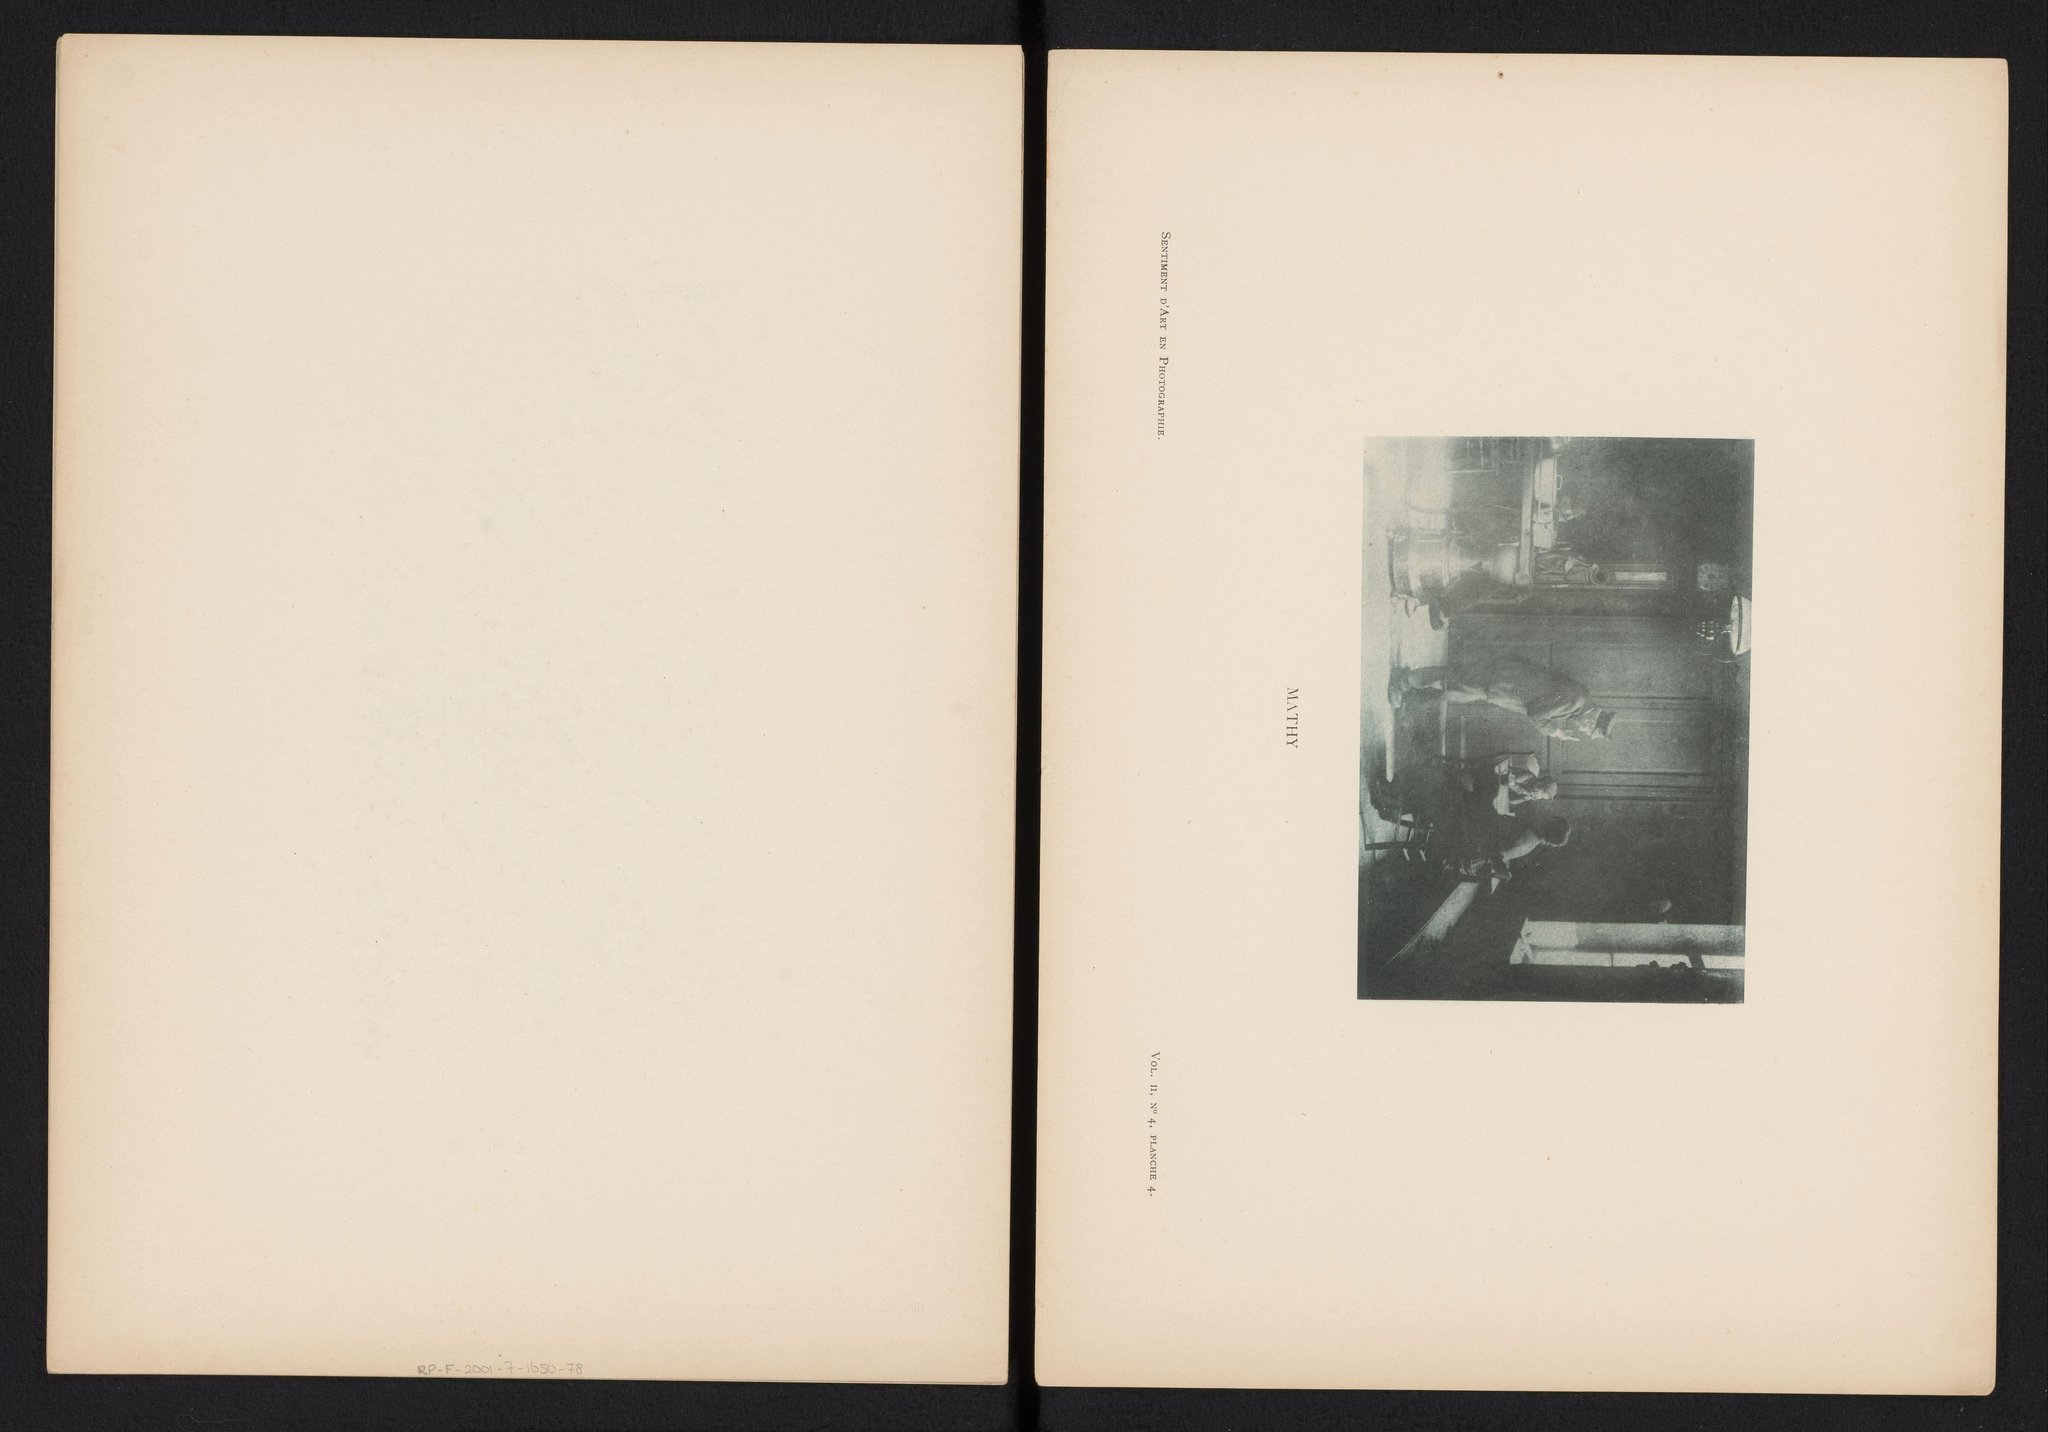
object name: photomechanical print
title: Vader en moeder berispen hun zoon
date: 1895-1900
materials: paper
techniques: photograph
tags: correction of naughty children, family life at home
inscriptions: number: ‘Vol. II, No 4, Planche 4.’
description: Deze prent maakt deel uit van 8 omslagen met 22 tekstbladen en 89 prenten op losse bladen in en tussen de omslagen.